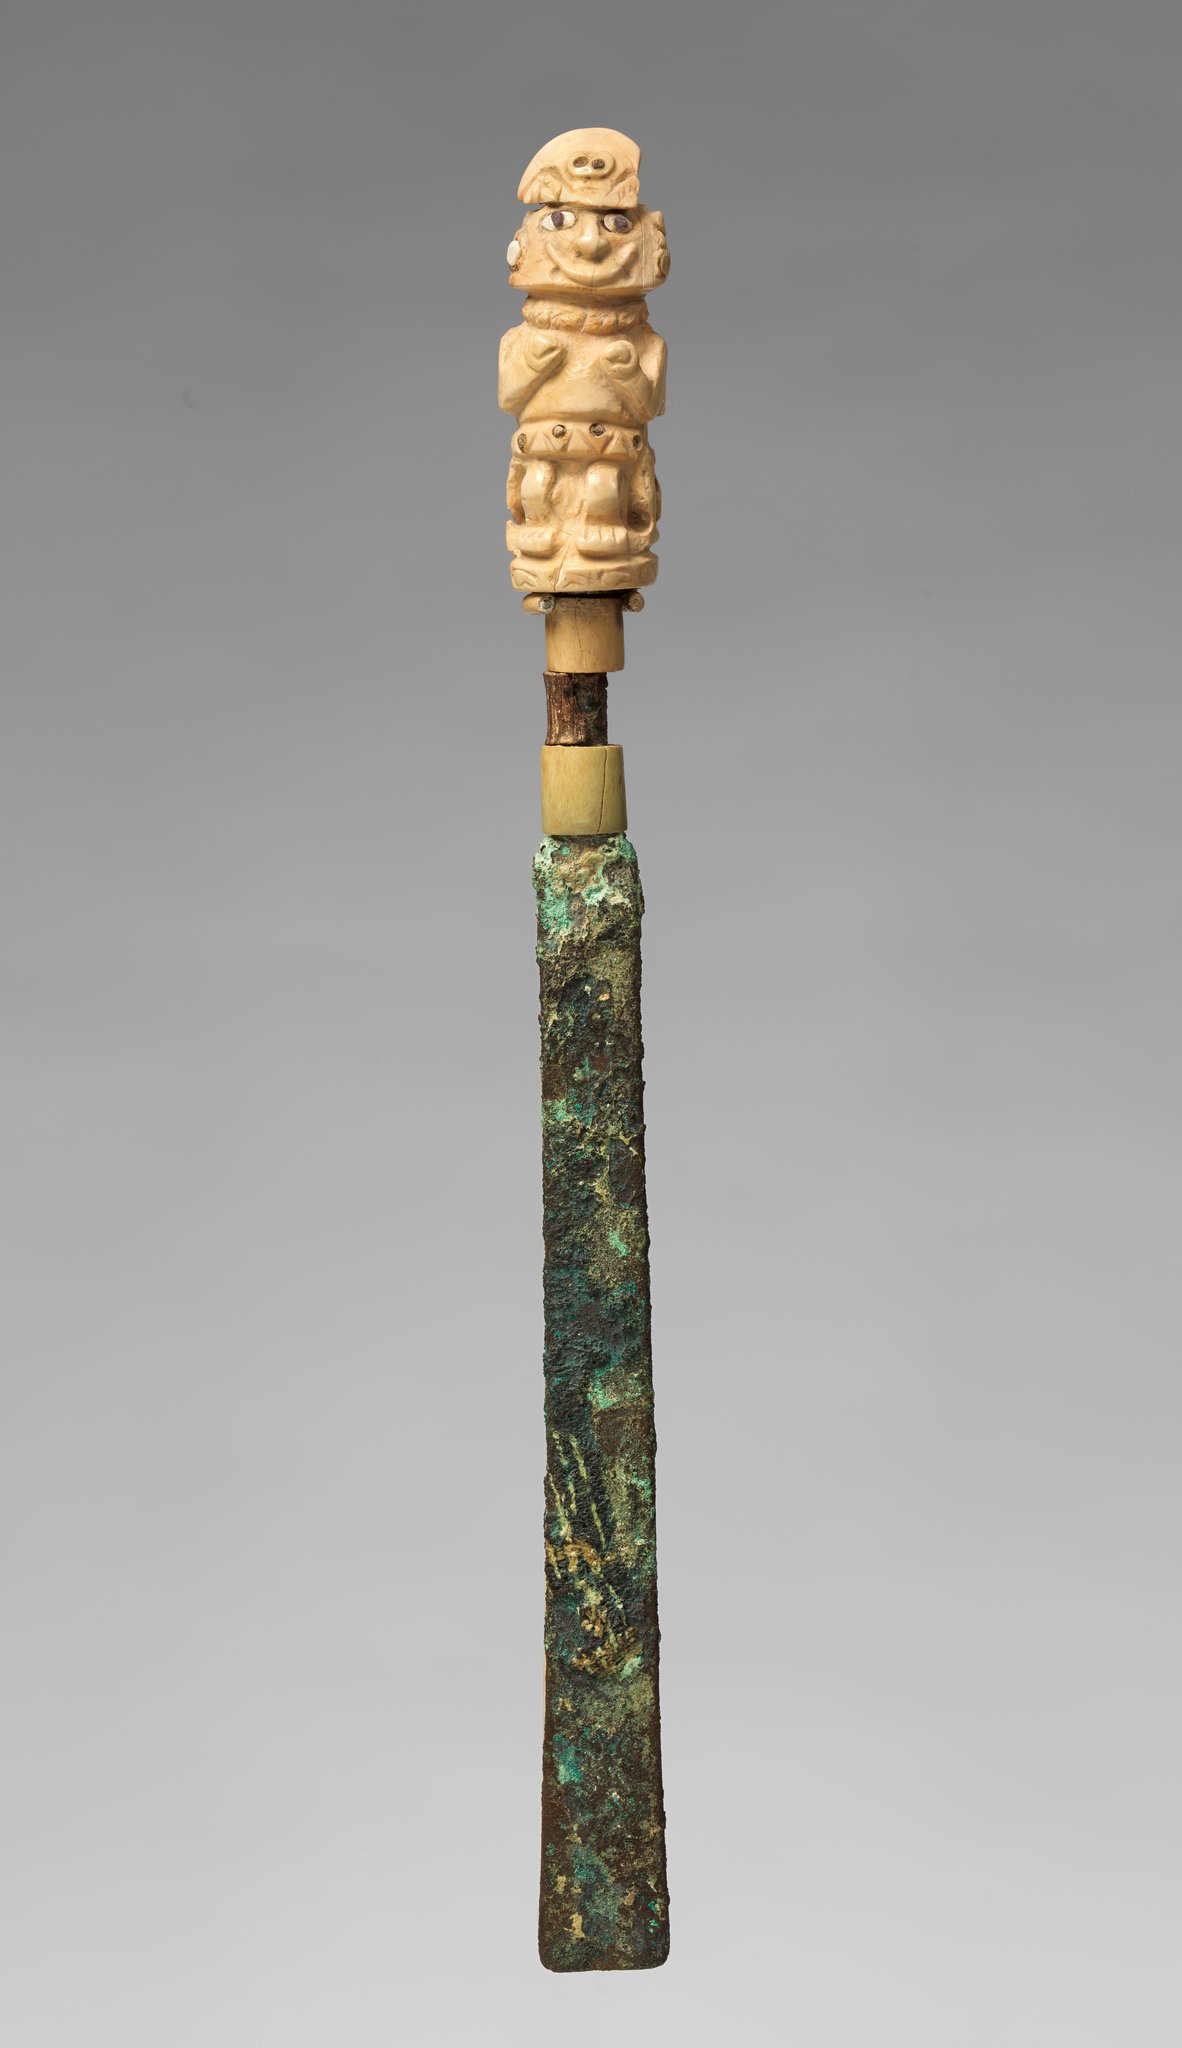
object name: spatula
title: Ornamented Spatula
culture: moche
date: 101-700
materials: copper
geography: peru